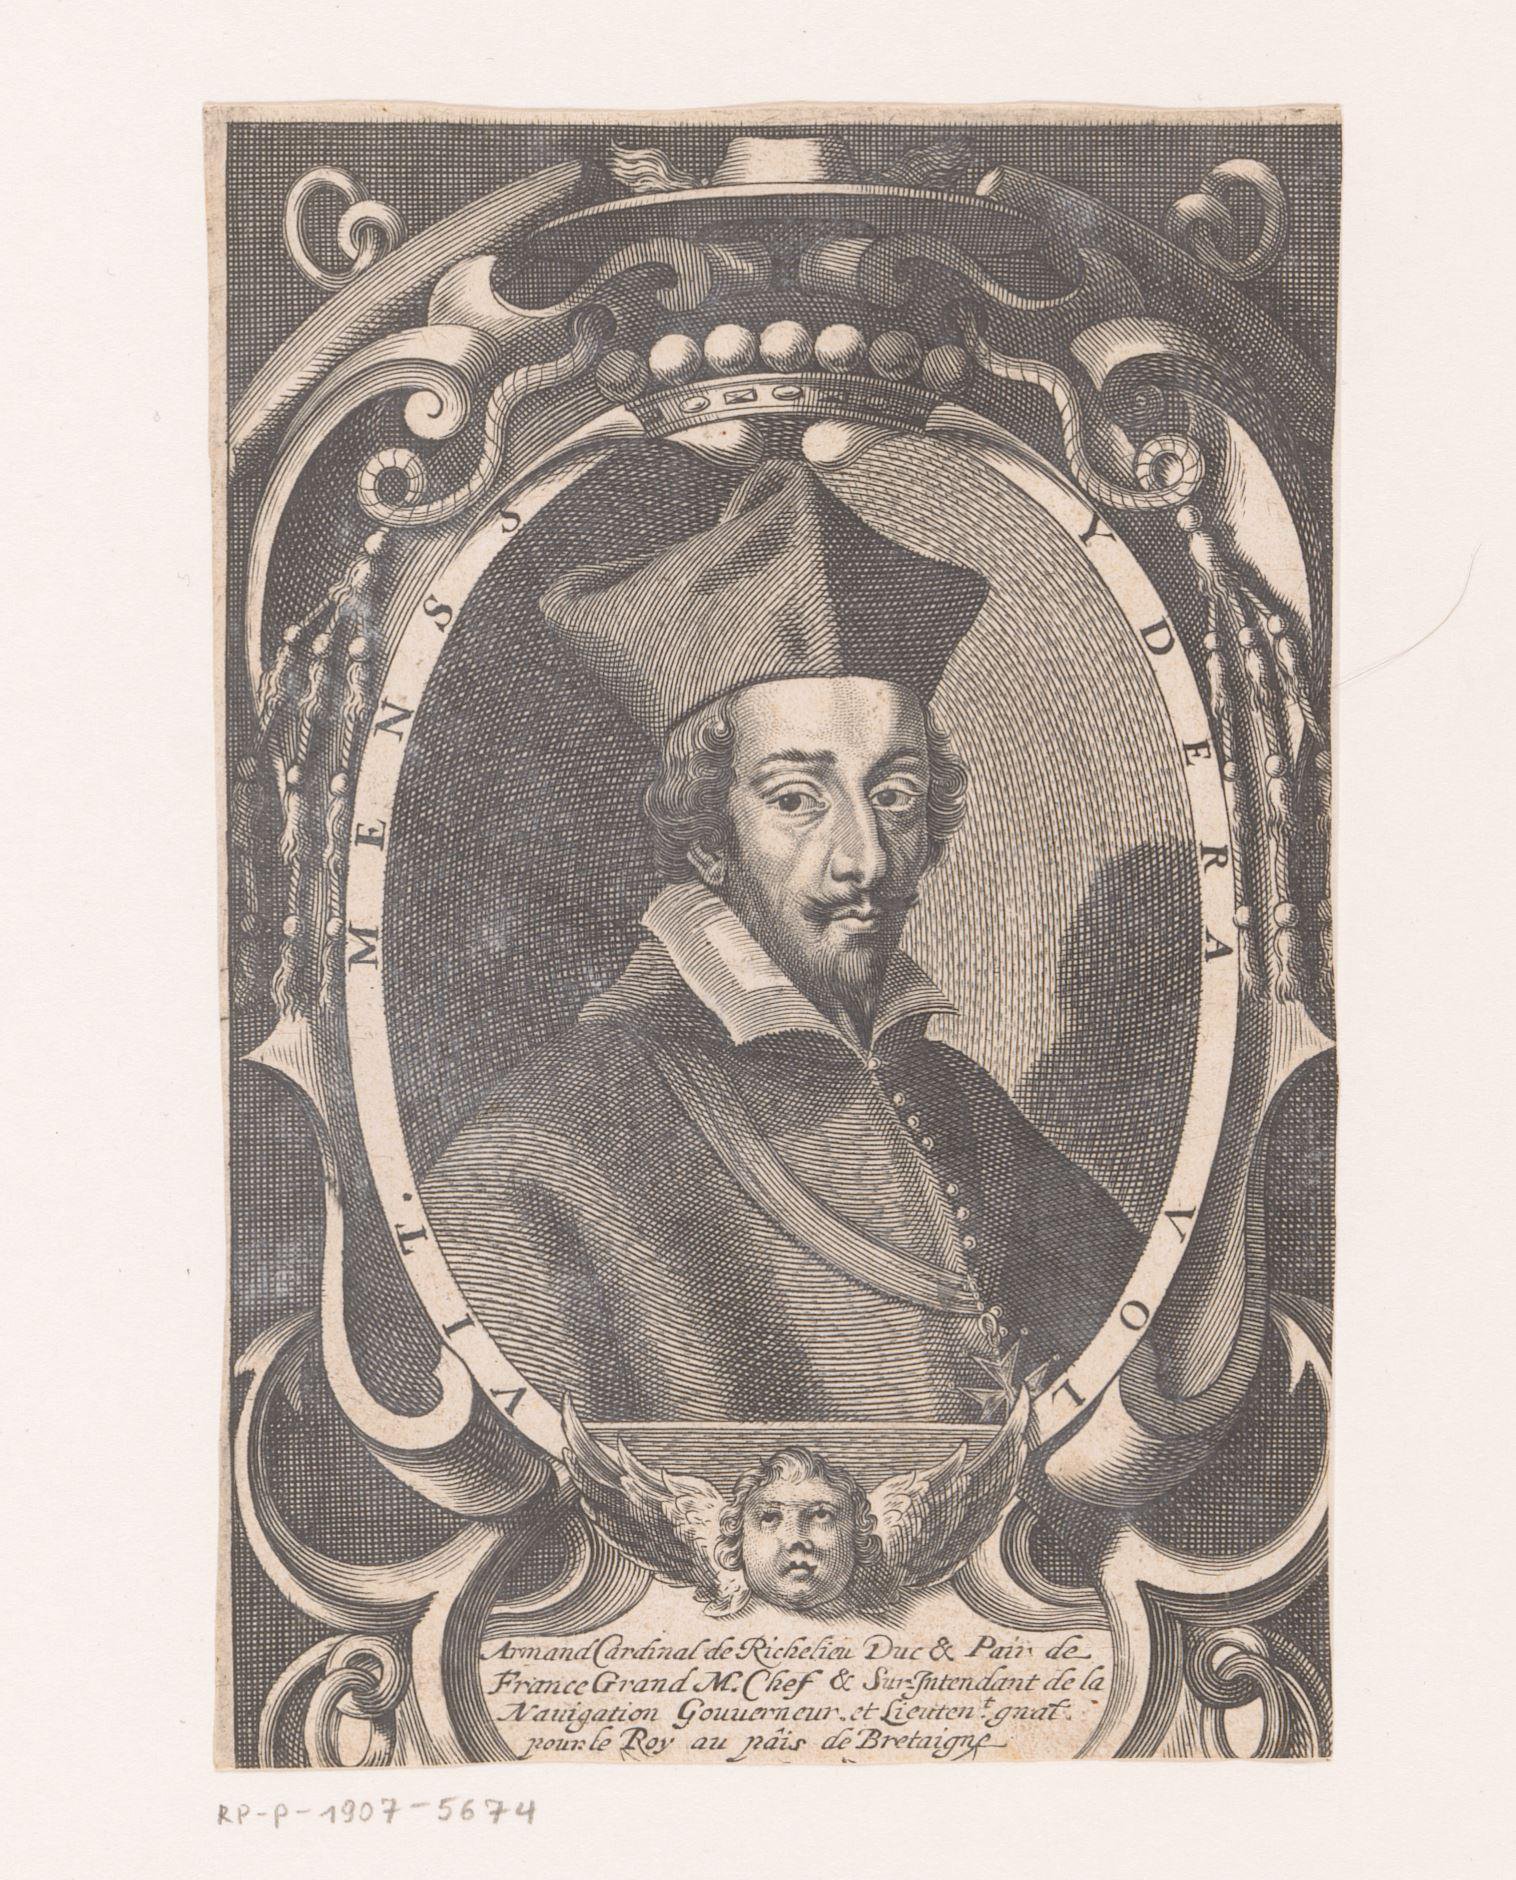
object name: print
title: Portret van kardinaal de Richelieu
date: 1610-1668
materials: paper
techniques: engraving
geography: paris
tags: paris, armand-jean du plessis hertog van richelieu, cardinal, historical persons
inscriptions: collector's mark: Lugt 2228